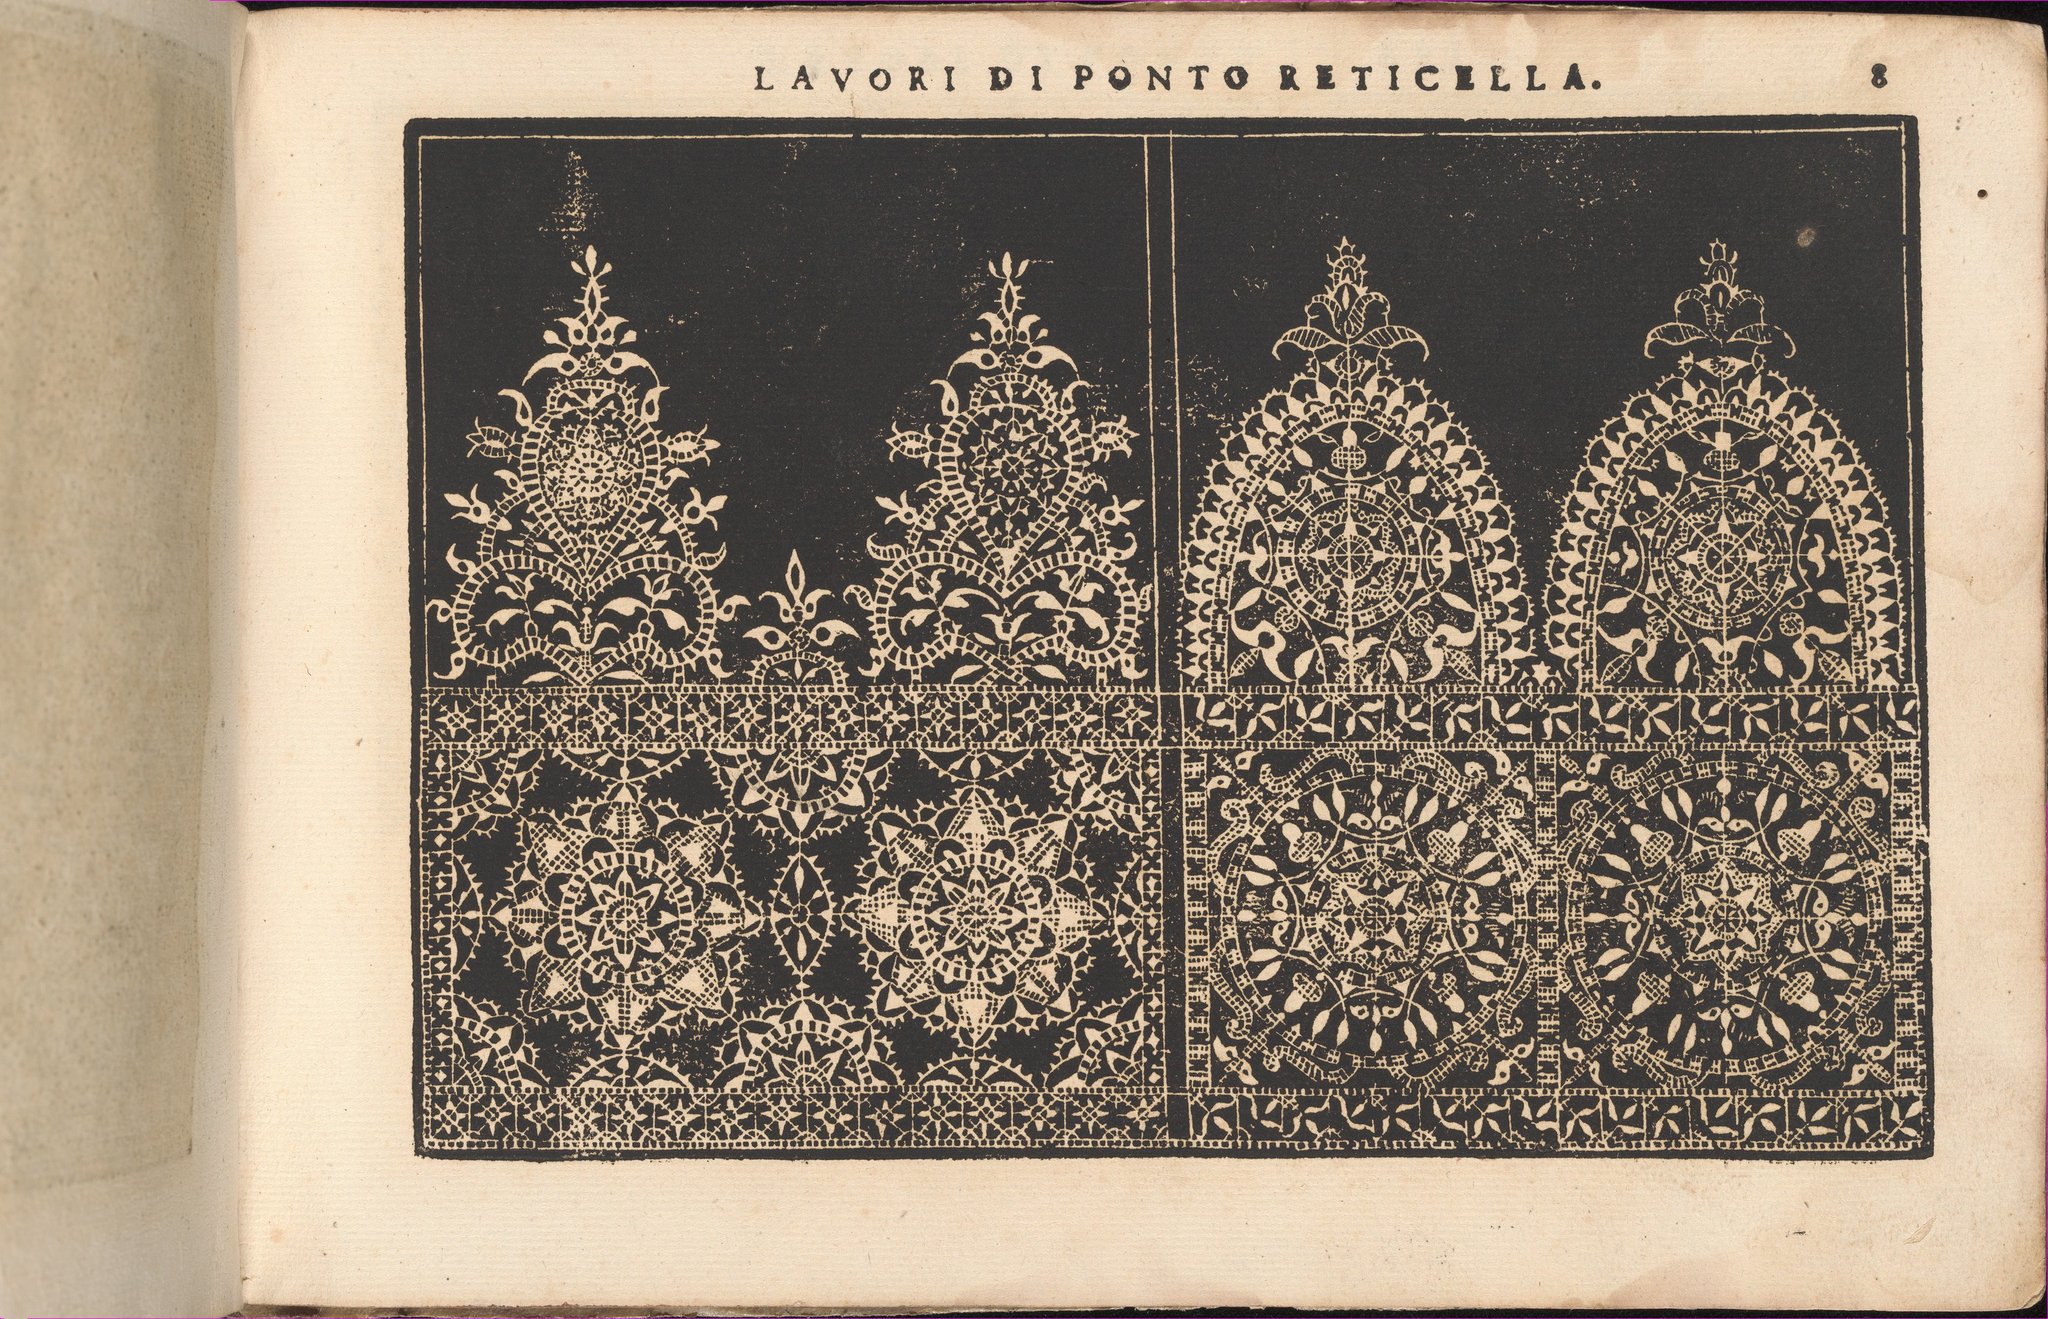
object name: book print ornament architecture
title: Teatro delle Nobili et Virtuose Donne..., page 10 (recto)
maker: isabella catanea parasole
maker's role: author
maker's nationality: italian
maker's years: 1565-1625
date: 1616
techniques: engraving, woodcut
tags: ornament